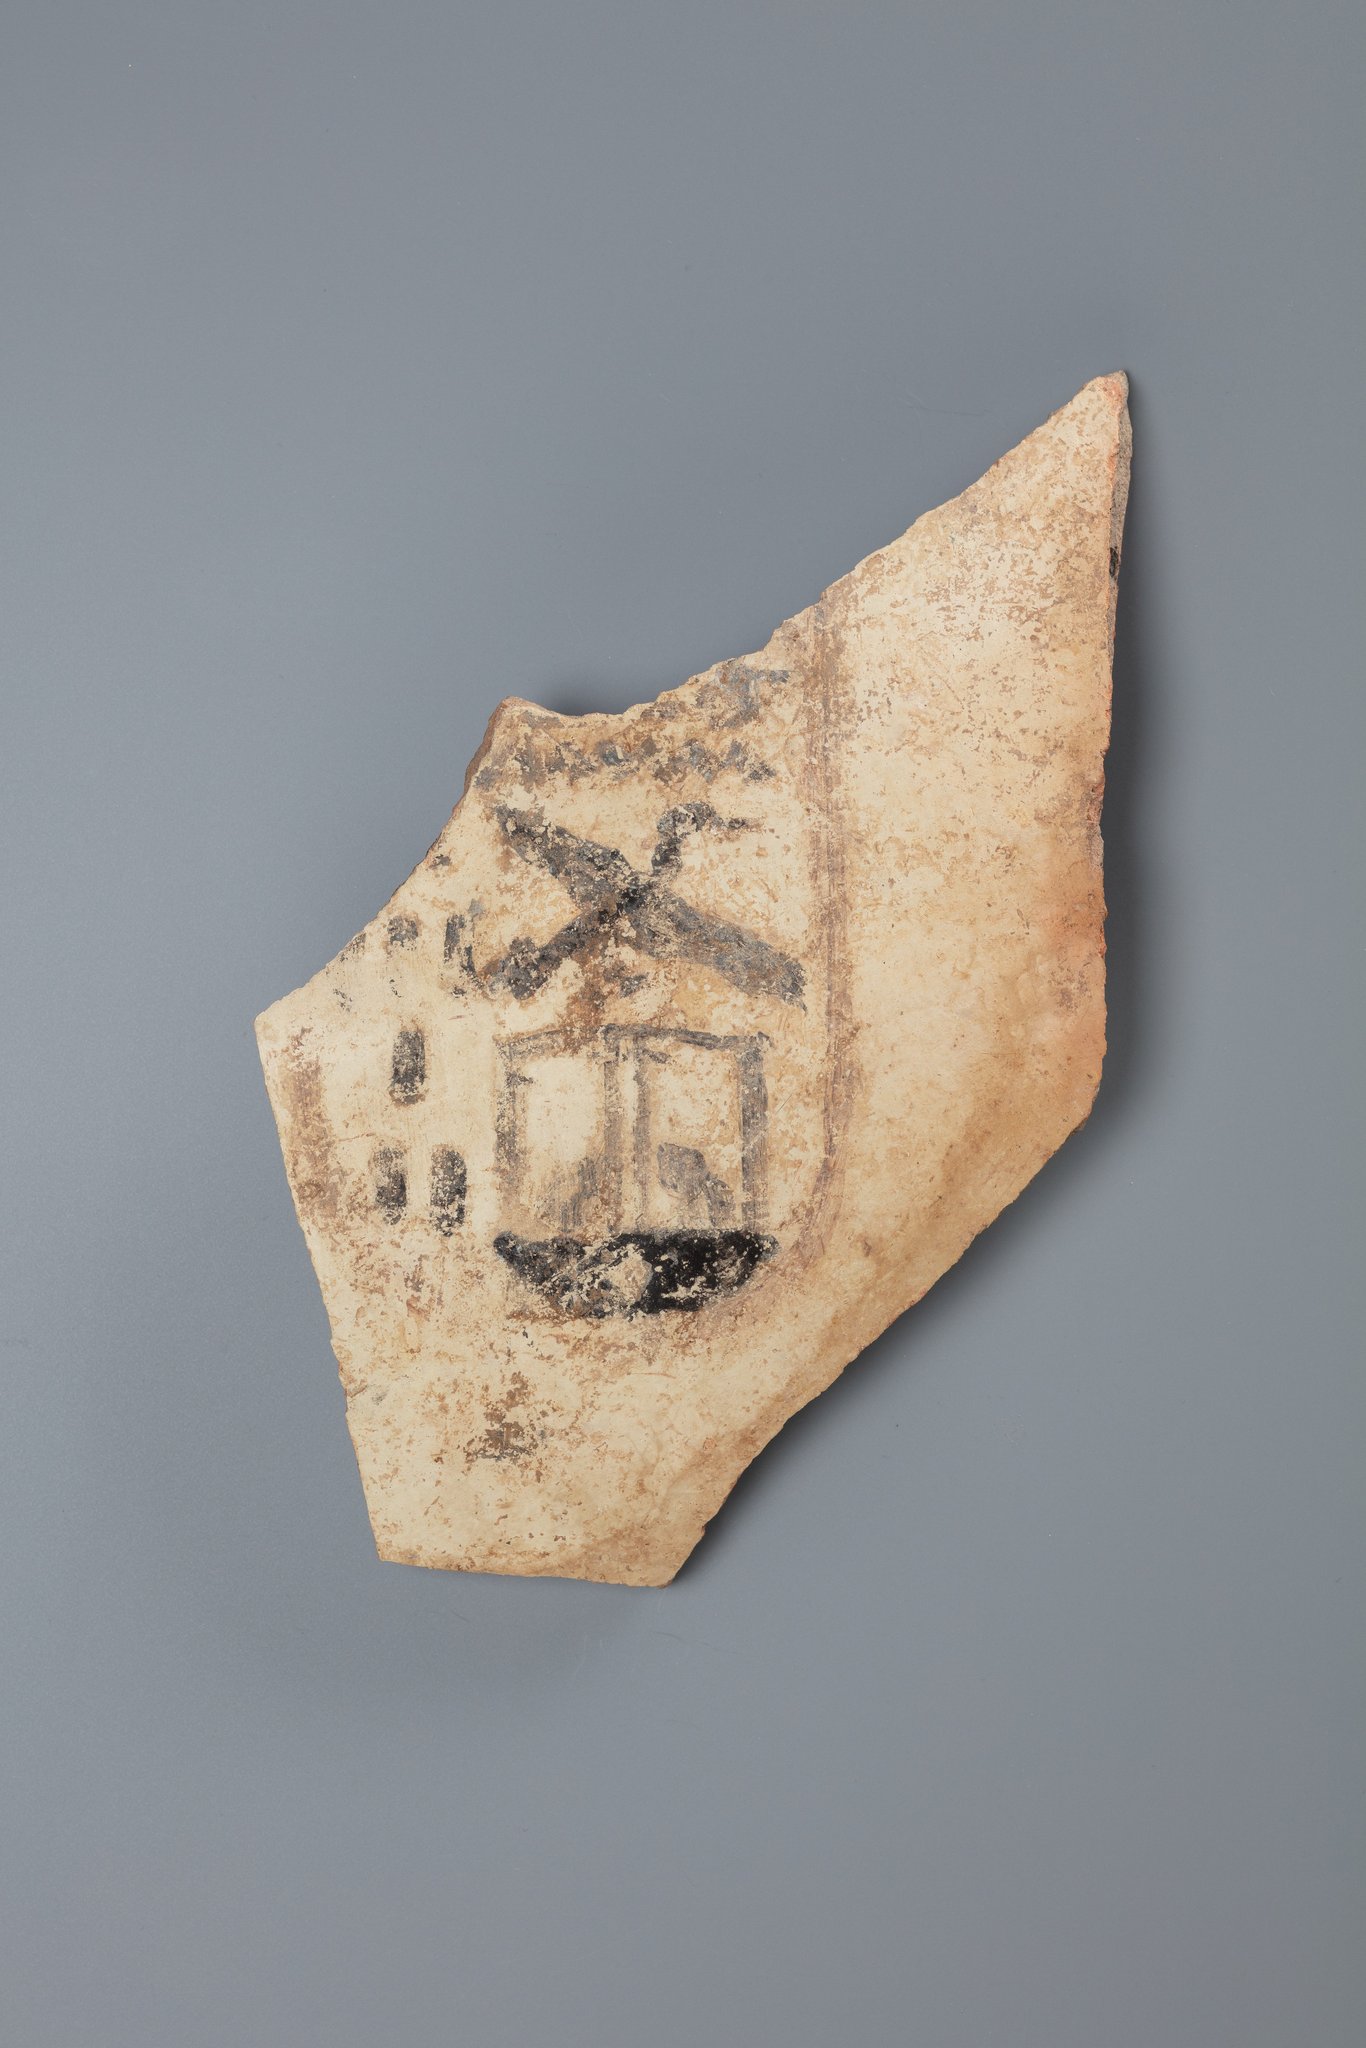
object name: jar label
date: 1390-1352 BCE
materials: ink, paint, pottery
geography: egypt